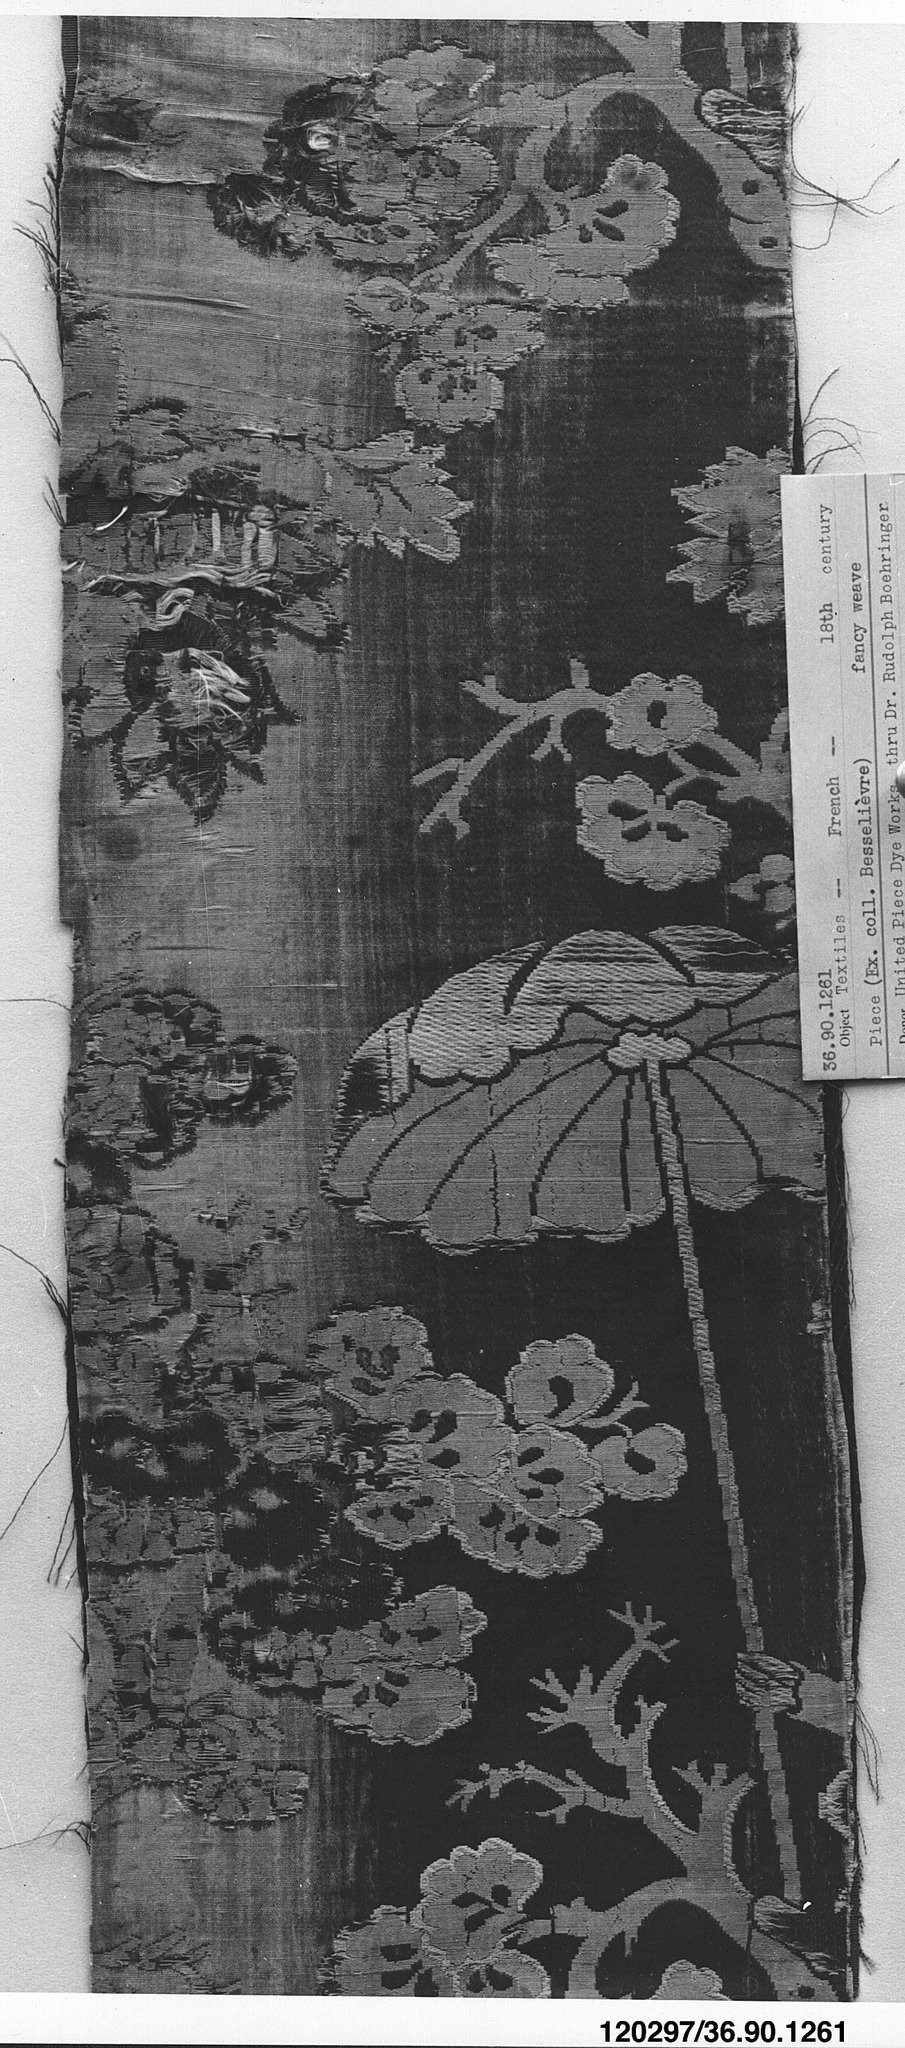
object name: piece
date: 1701-1800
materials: silk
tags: leaves